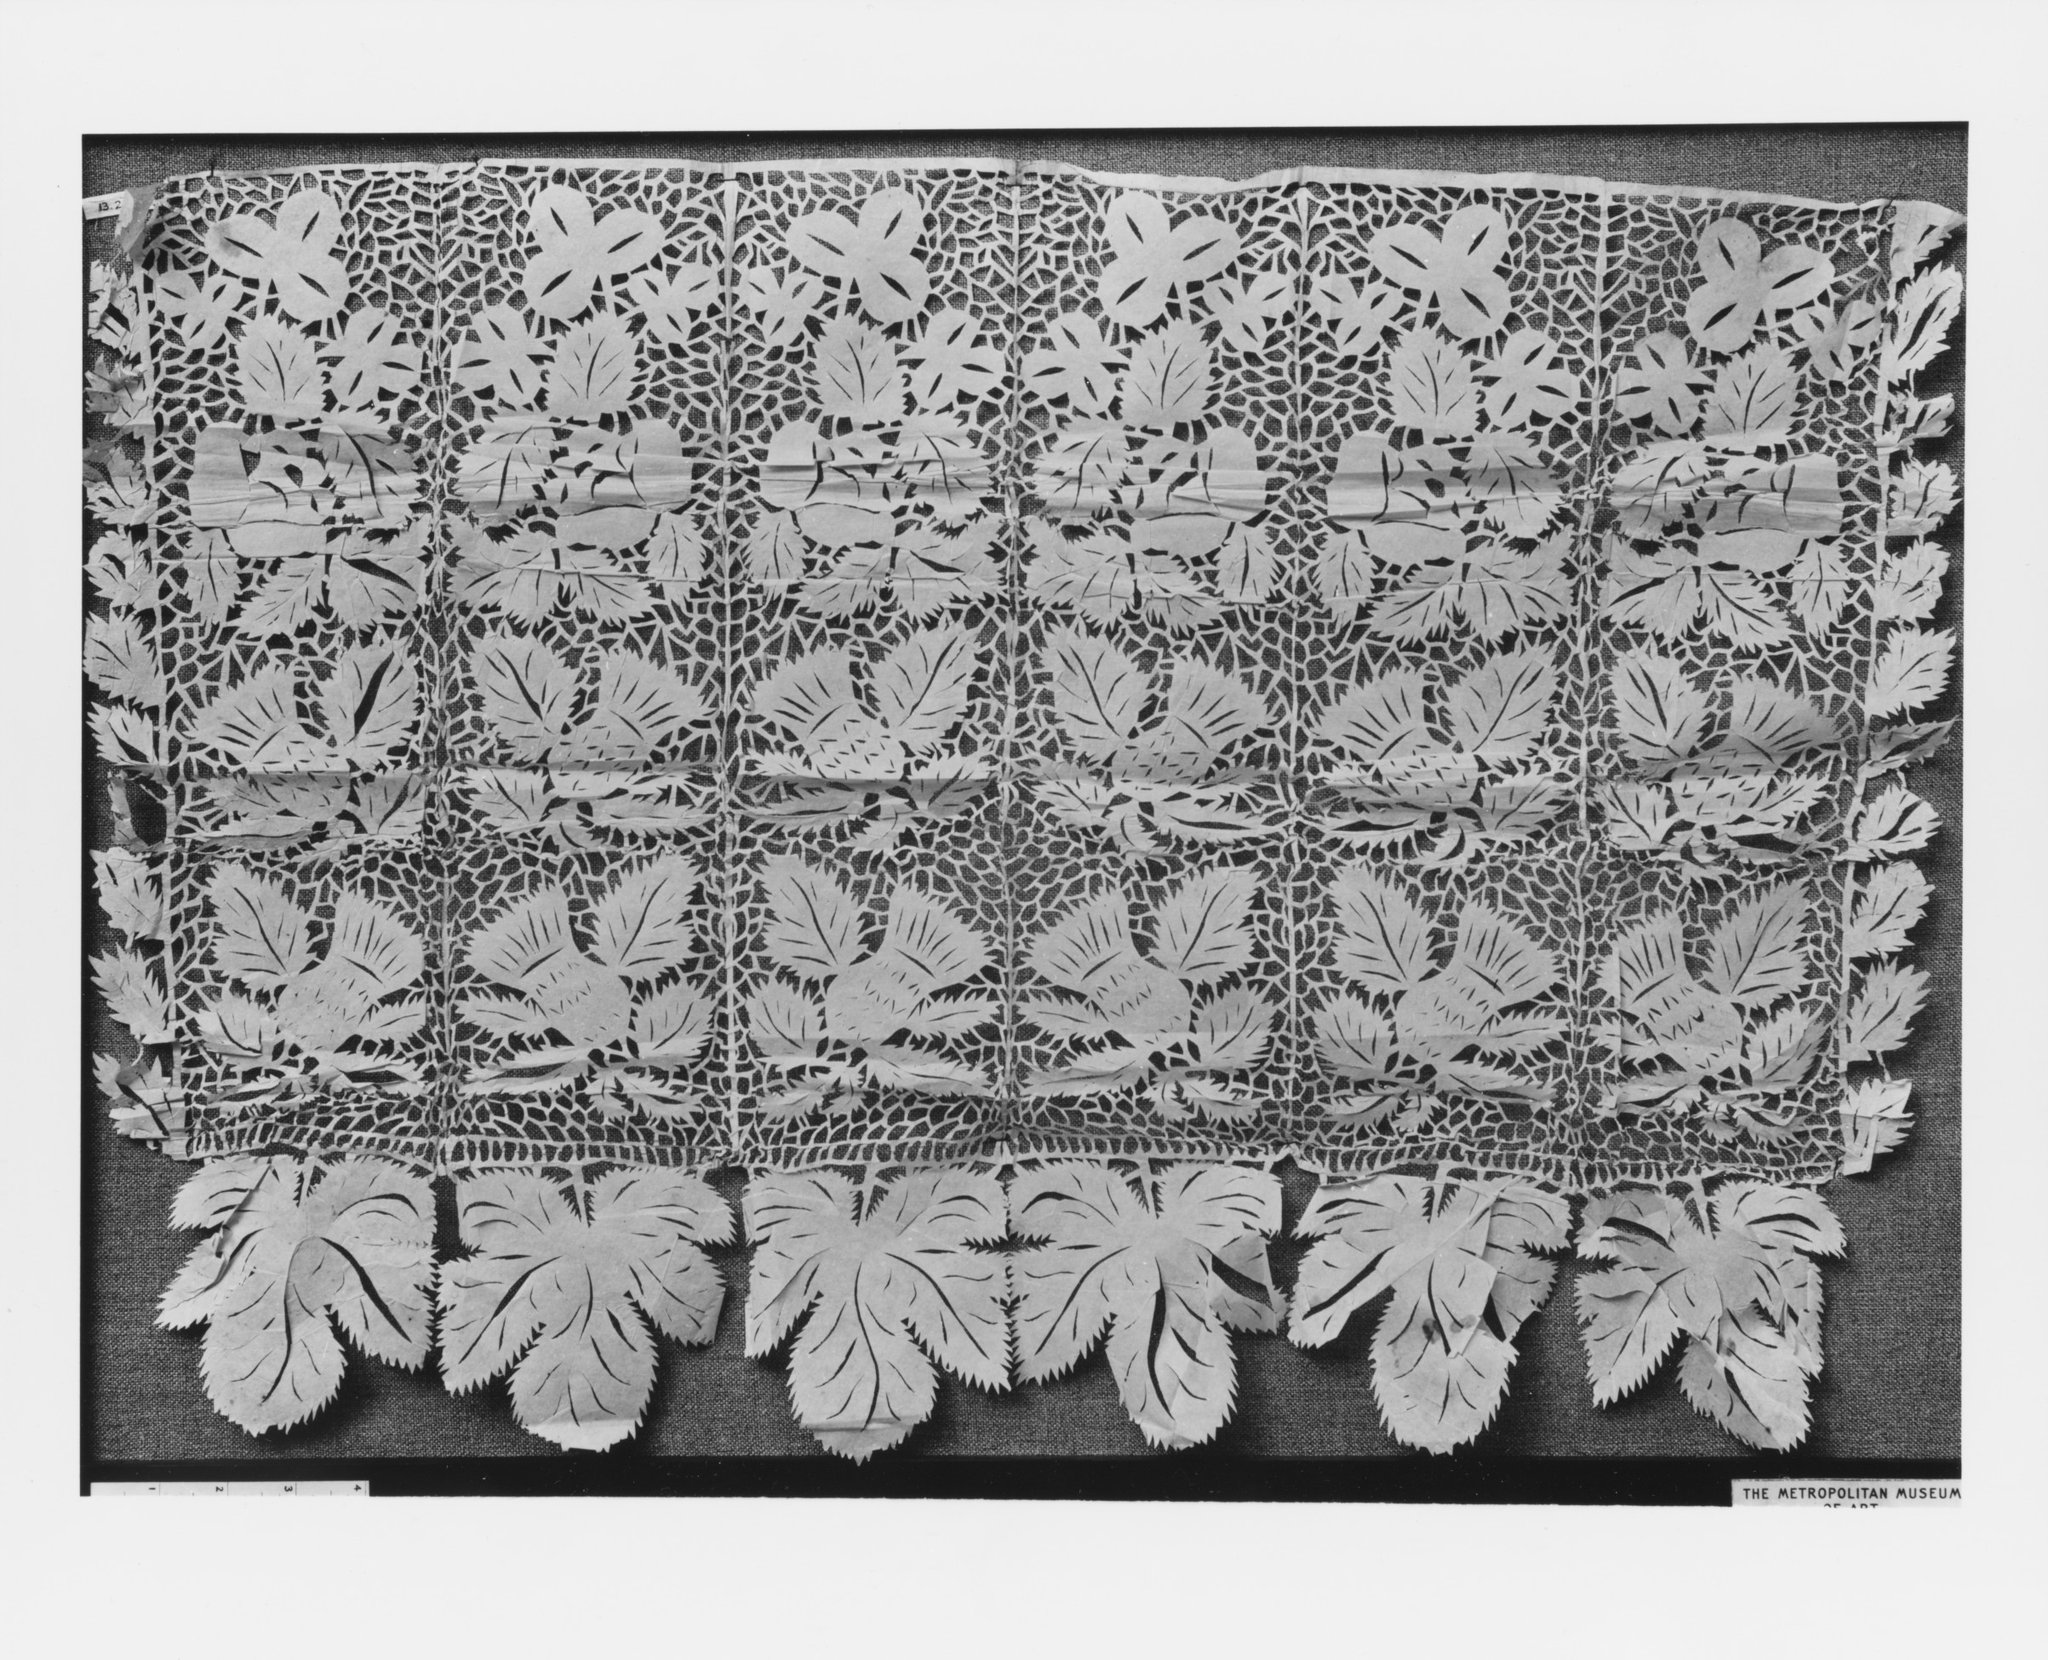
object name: lace pattern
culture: american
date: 1831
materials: paper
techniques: cutting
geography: united states